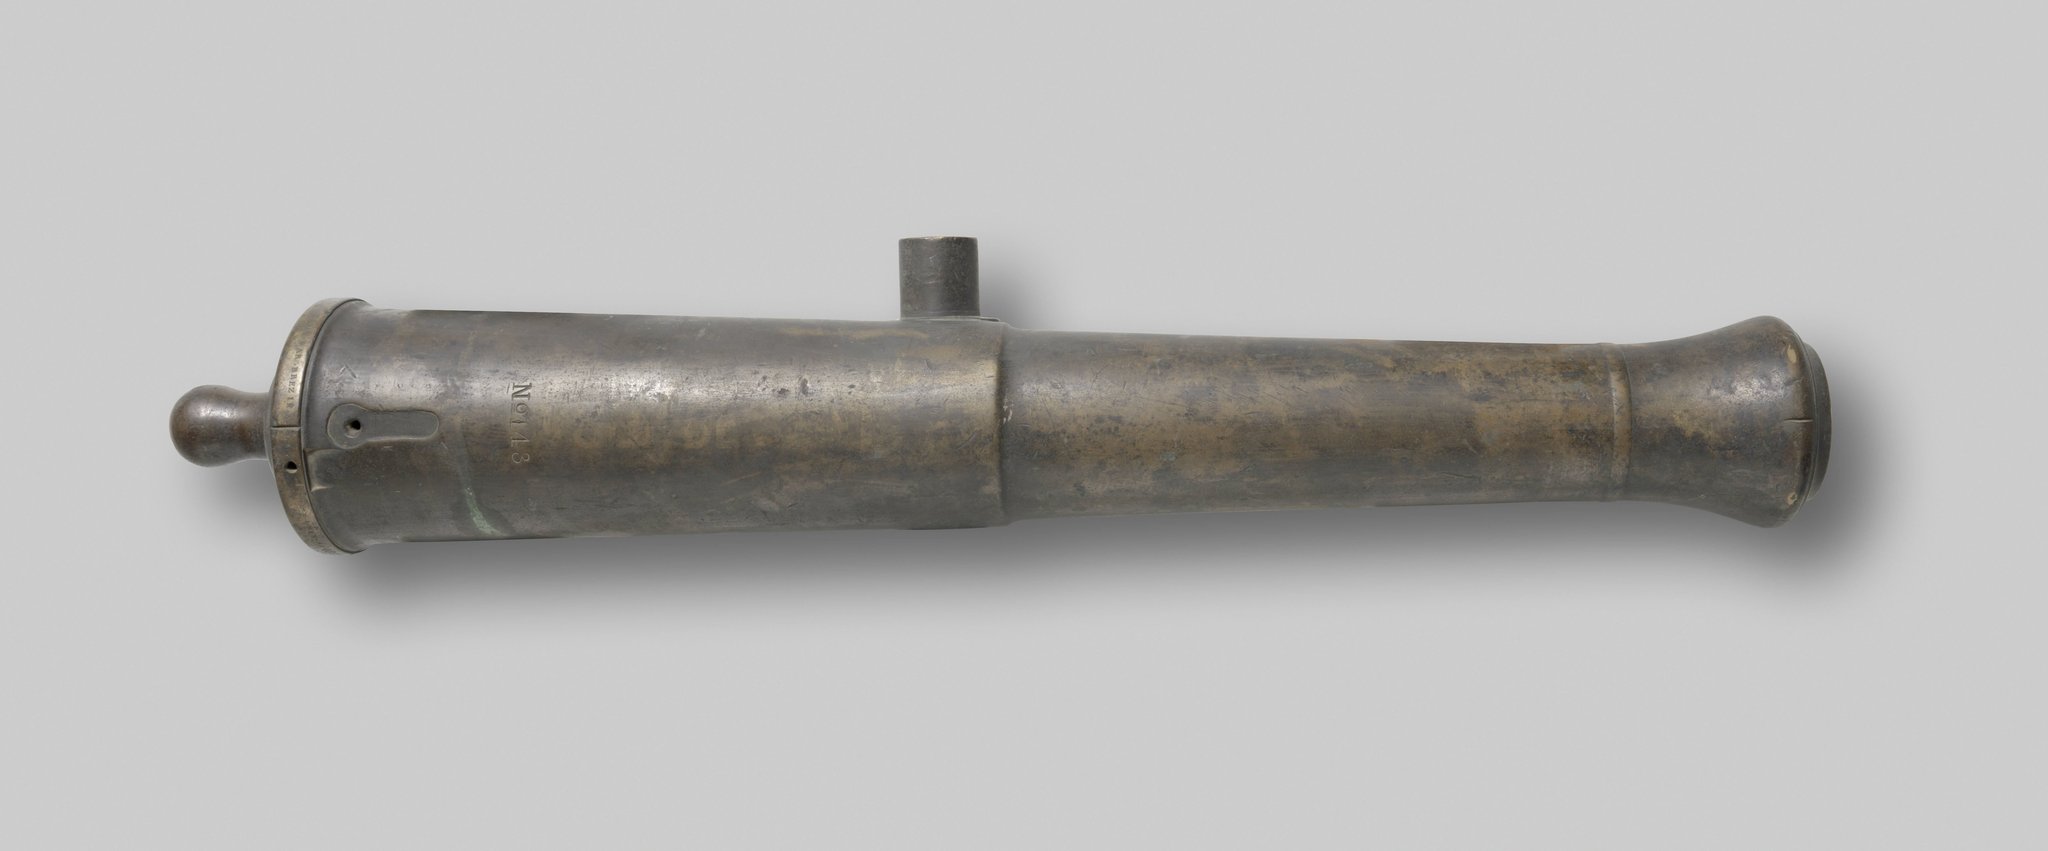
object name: cannon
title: Draaibas n° 143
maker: michel brézin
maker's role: geschutgieter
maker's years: 1758-1828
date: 1812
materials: bronze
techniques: casting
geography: paris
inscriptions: inscription: ‘N:O. / 35.’, : ‘.P:D: / 85.K5.’, inscription: ‘N° 143’, signature and date: ‘FAIT . PAR . BREZIN . ALA ... . PARIS . AN . 1812’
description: Glad kanon met ronde druif. In achterzijde bodemstuk een rond gaatje. Kulasband met opschrift. Bovenop kerf en rechts darvan rond gaatje. Zundgat in peervormige omtrek. Hierboven opschrift. Halverwege breuk en twee gladde gegraveerde tappen. Gladde halsband en iets uitlopende monding. Op bovenzijde kop kerf in rand voor het richten.